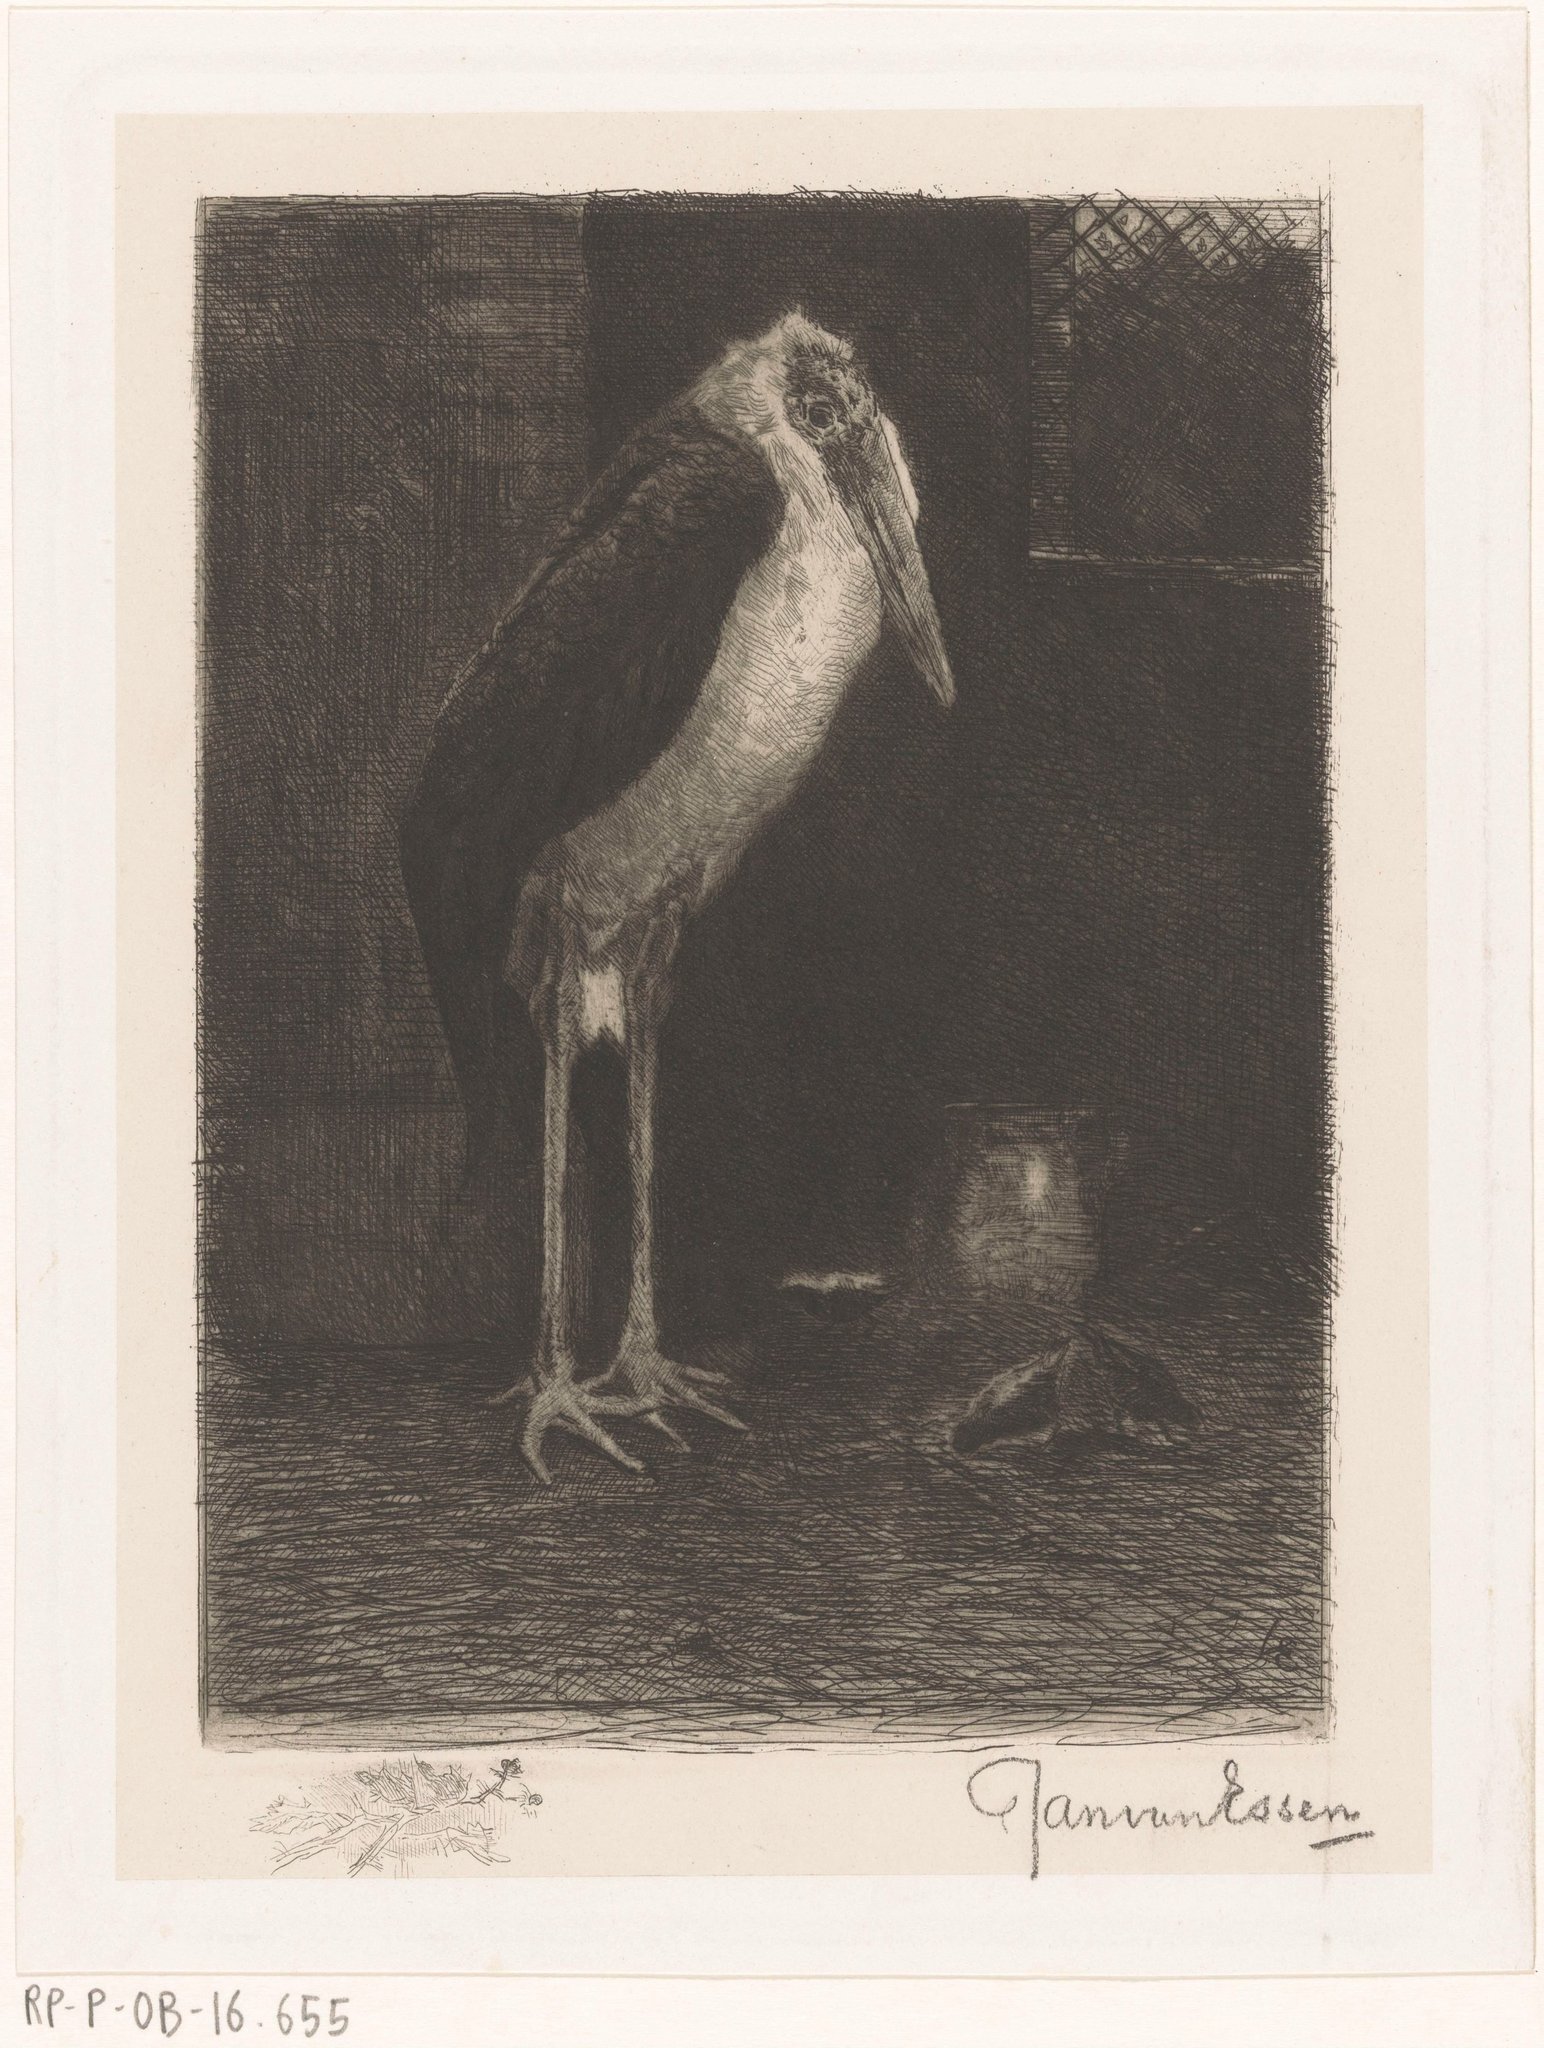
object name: print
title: Maraboe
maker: jan van essen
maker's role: draughtsman, print maker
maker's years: 1854-1936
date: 1864-1936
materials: paper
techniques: etching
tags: shore-birds and wading-birds: marabou, zoological garden, zoo, seen as place where non-domestic animals are kept (+ stable, shed, kennel)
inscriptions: collector's mark: Lugt 2228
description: Een maraboe in een verblijf met een met gaas bespannen raam. Op de grond een kan en drie scharrelende vogels. Linksonder een tak met bladeren.